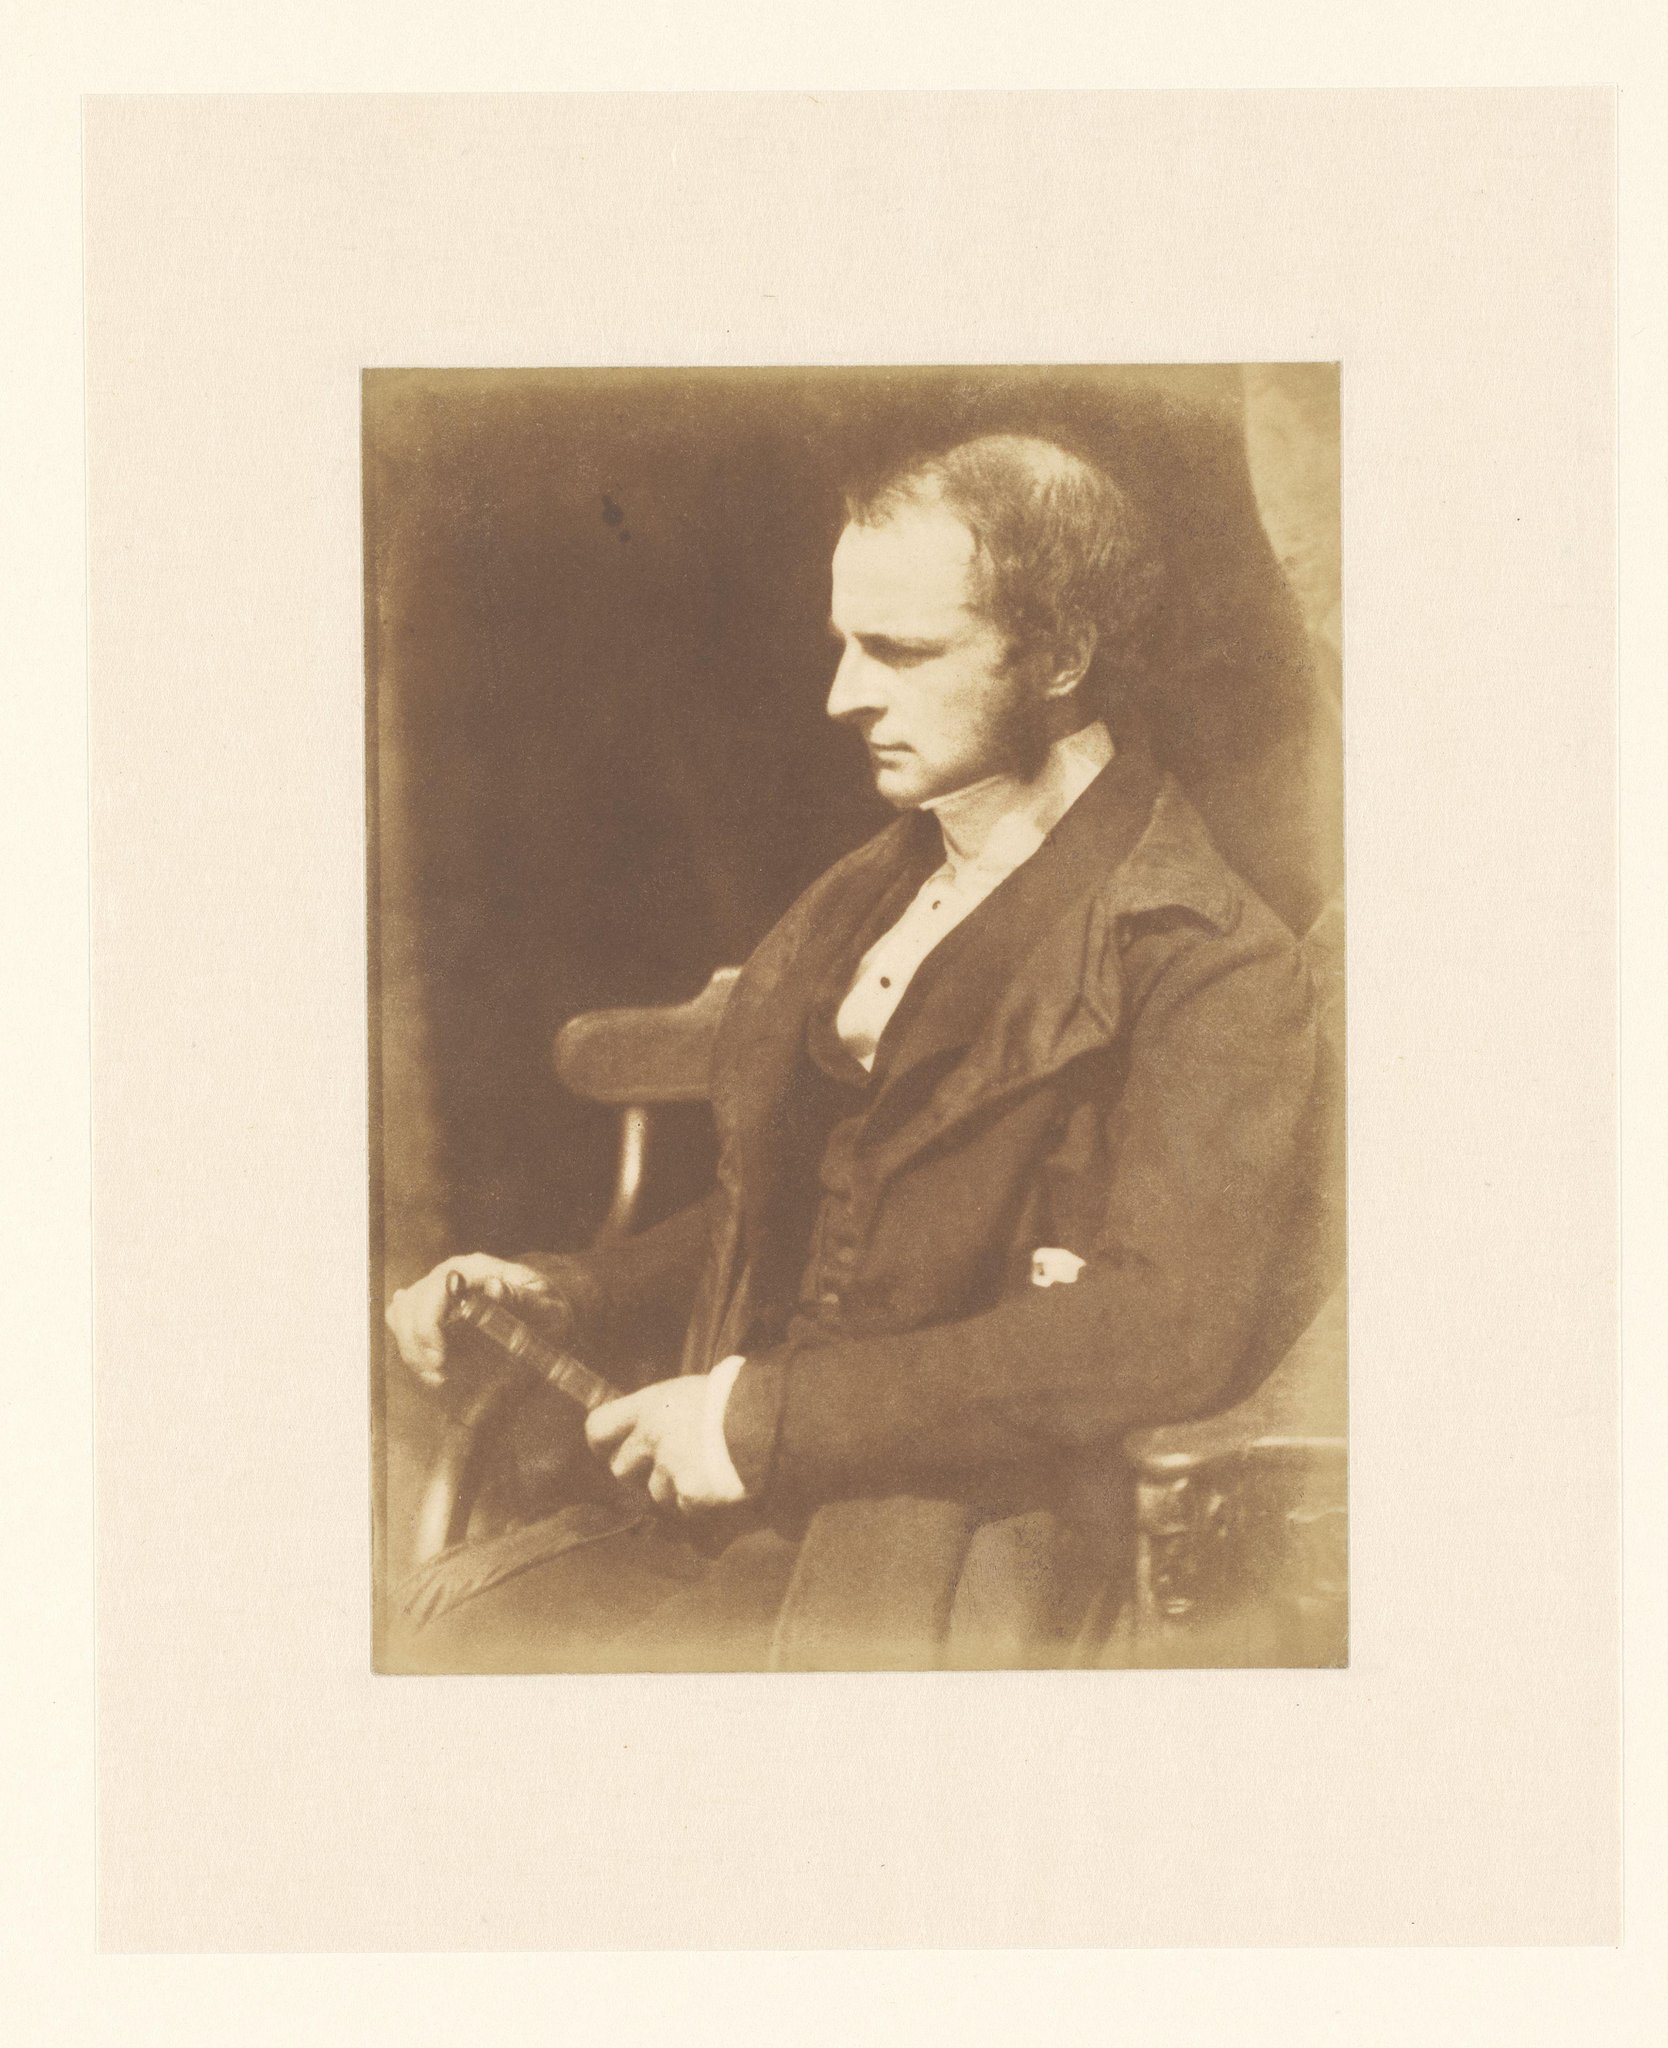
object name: photograph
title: Portrait of Reverend James Scott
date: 1843-1847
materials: photographic support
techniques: salted paper print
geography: scotland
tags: functionaries and dignitaries (with name) ~ protestant churches, historical persons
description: In 1843 the painter Hill began working on a group portrait of 450 clergymen. To spare himself time and effort, Hill called on the photographer Adamson to take portraits for use as preparatory studies. Hill was so captivated by the new medium that together with Adamson he began photographing other subjects as well. Nowadays, Hill is far better known for his photographs than his paintings.